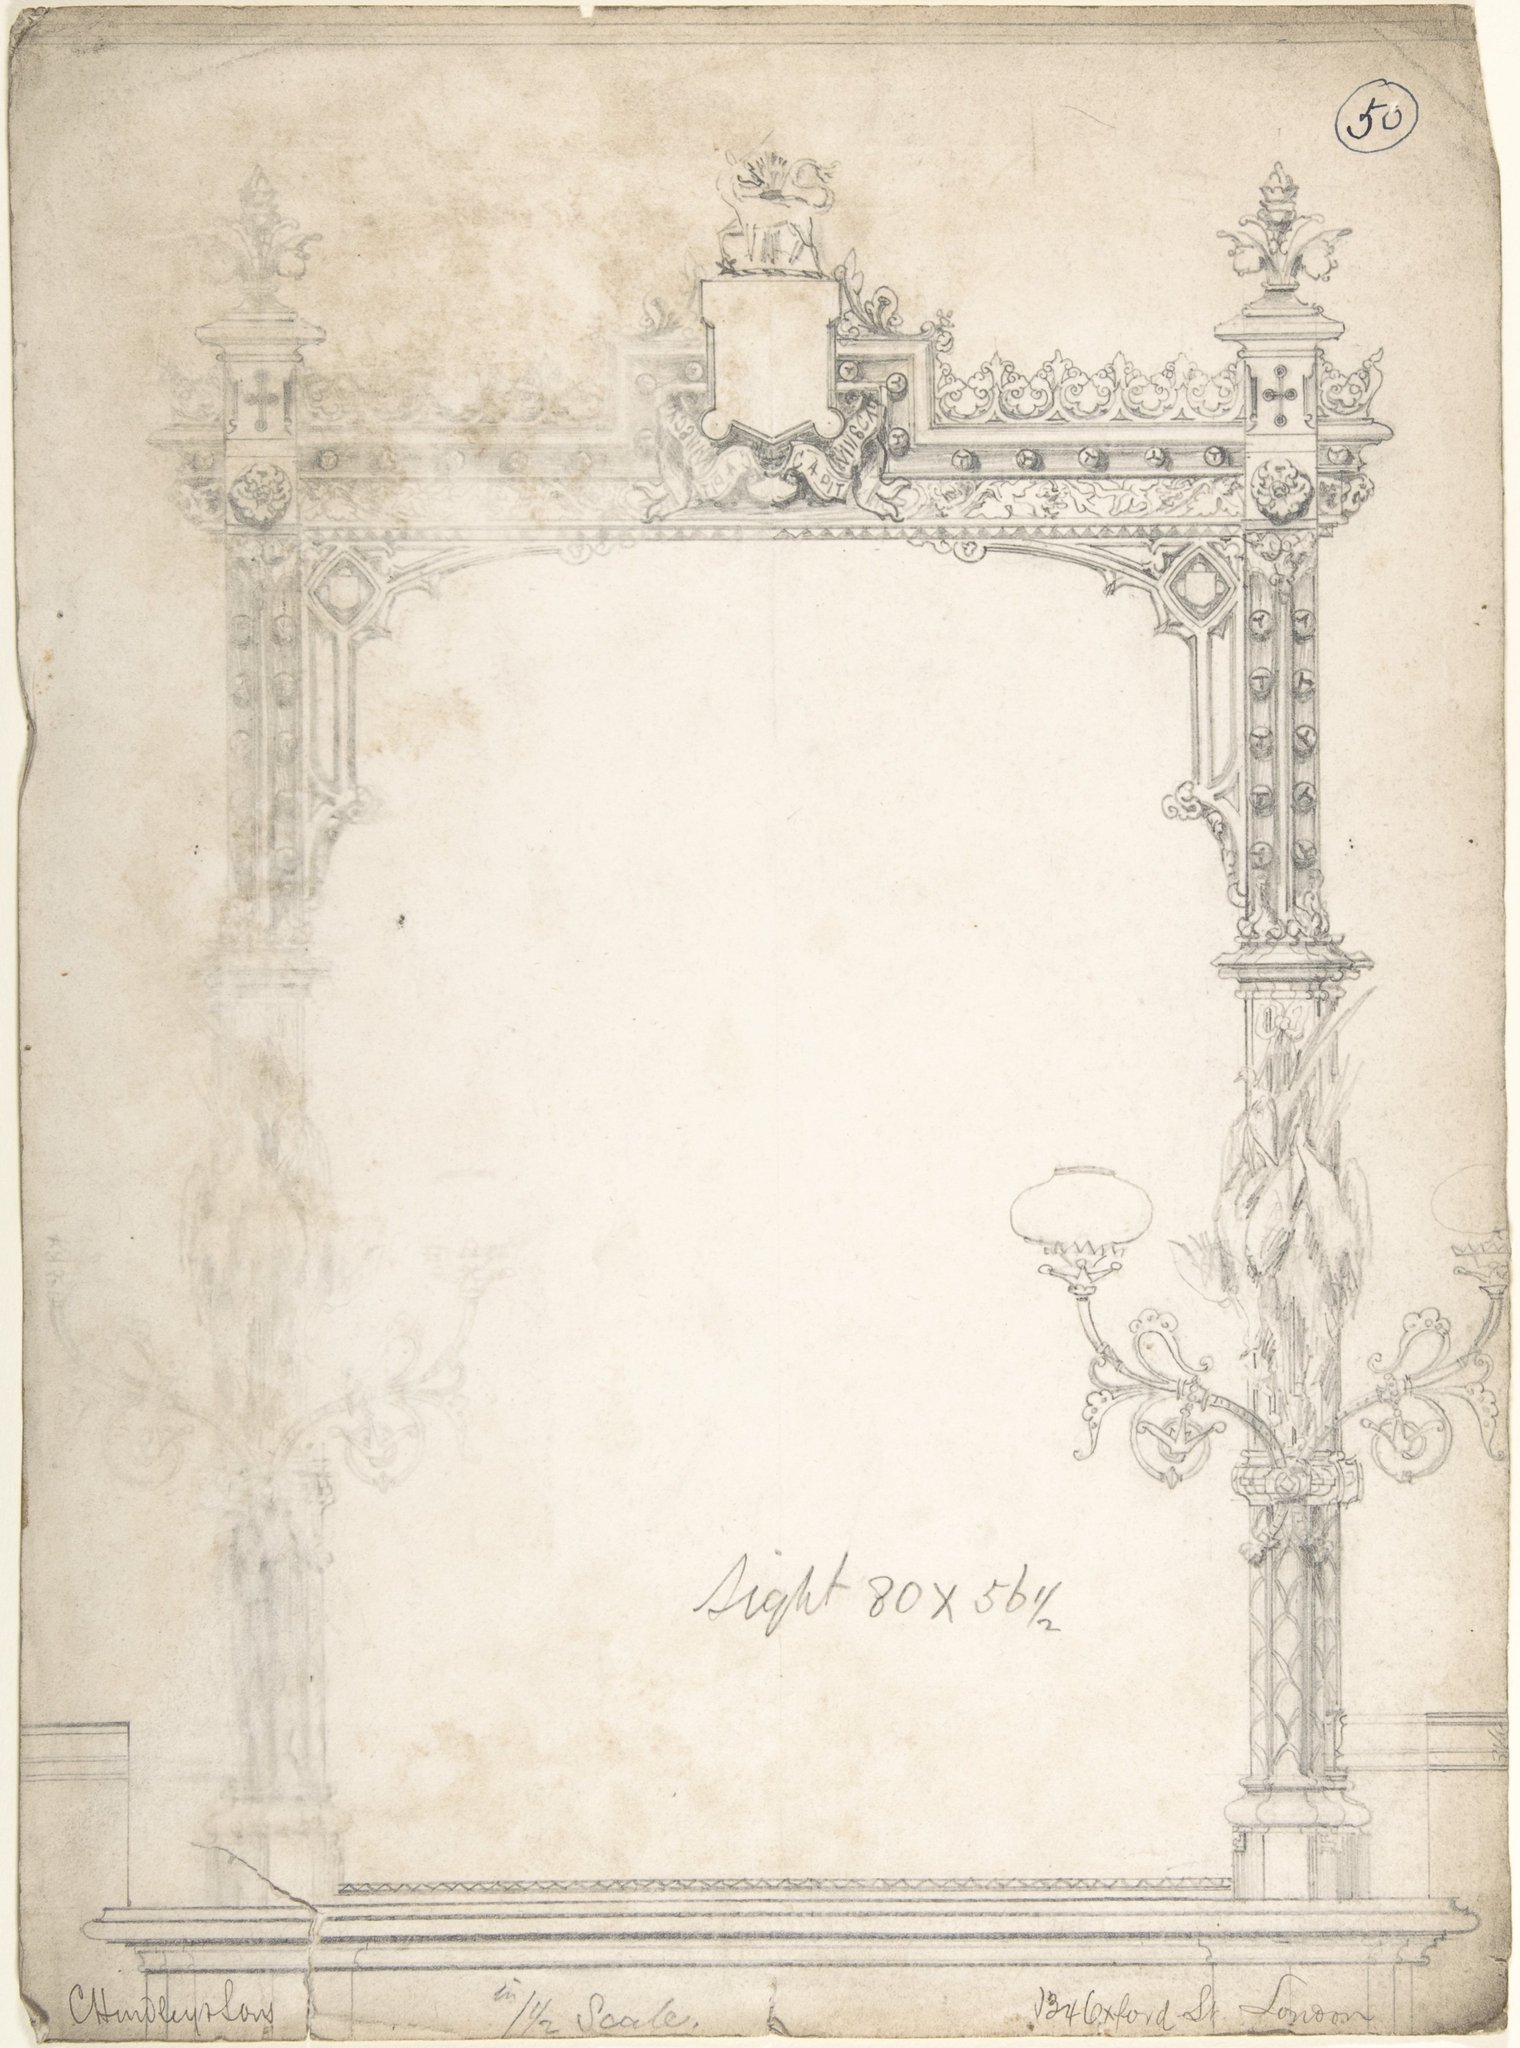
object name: drawing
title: Design for a Frame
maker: charles hindley and sons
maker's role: artist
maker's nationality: british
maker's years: 1841-1917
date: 1841-1884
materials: graphite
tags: architecture